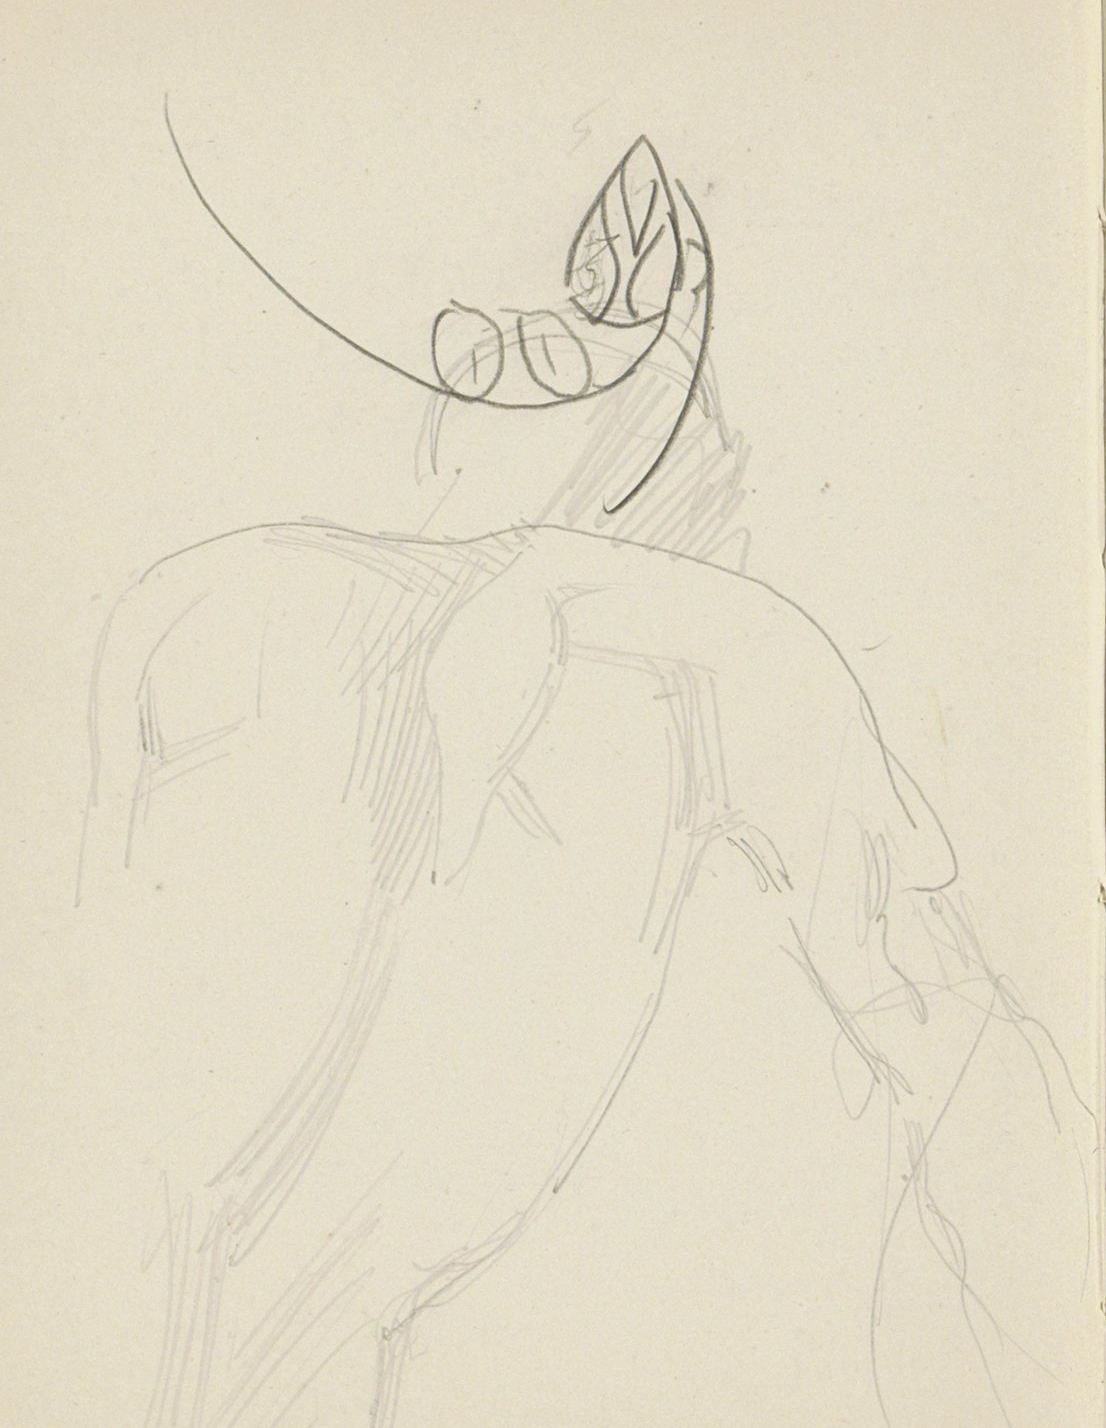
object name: sketchbook leaf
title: Rug van een naakte figuur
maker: reijer stolk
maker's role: draughtsman, print maker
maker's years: 1896-1945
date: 1906-1945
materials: paper, pencil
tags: back (+ nude human being)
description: Tevens een studie, mogelijk van een blad. Blad 52 verso uit een schetsboek met 69 bladen.